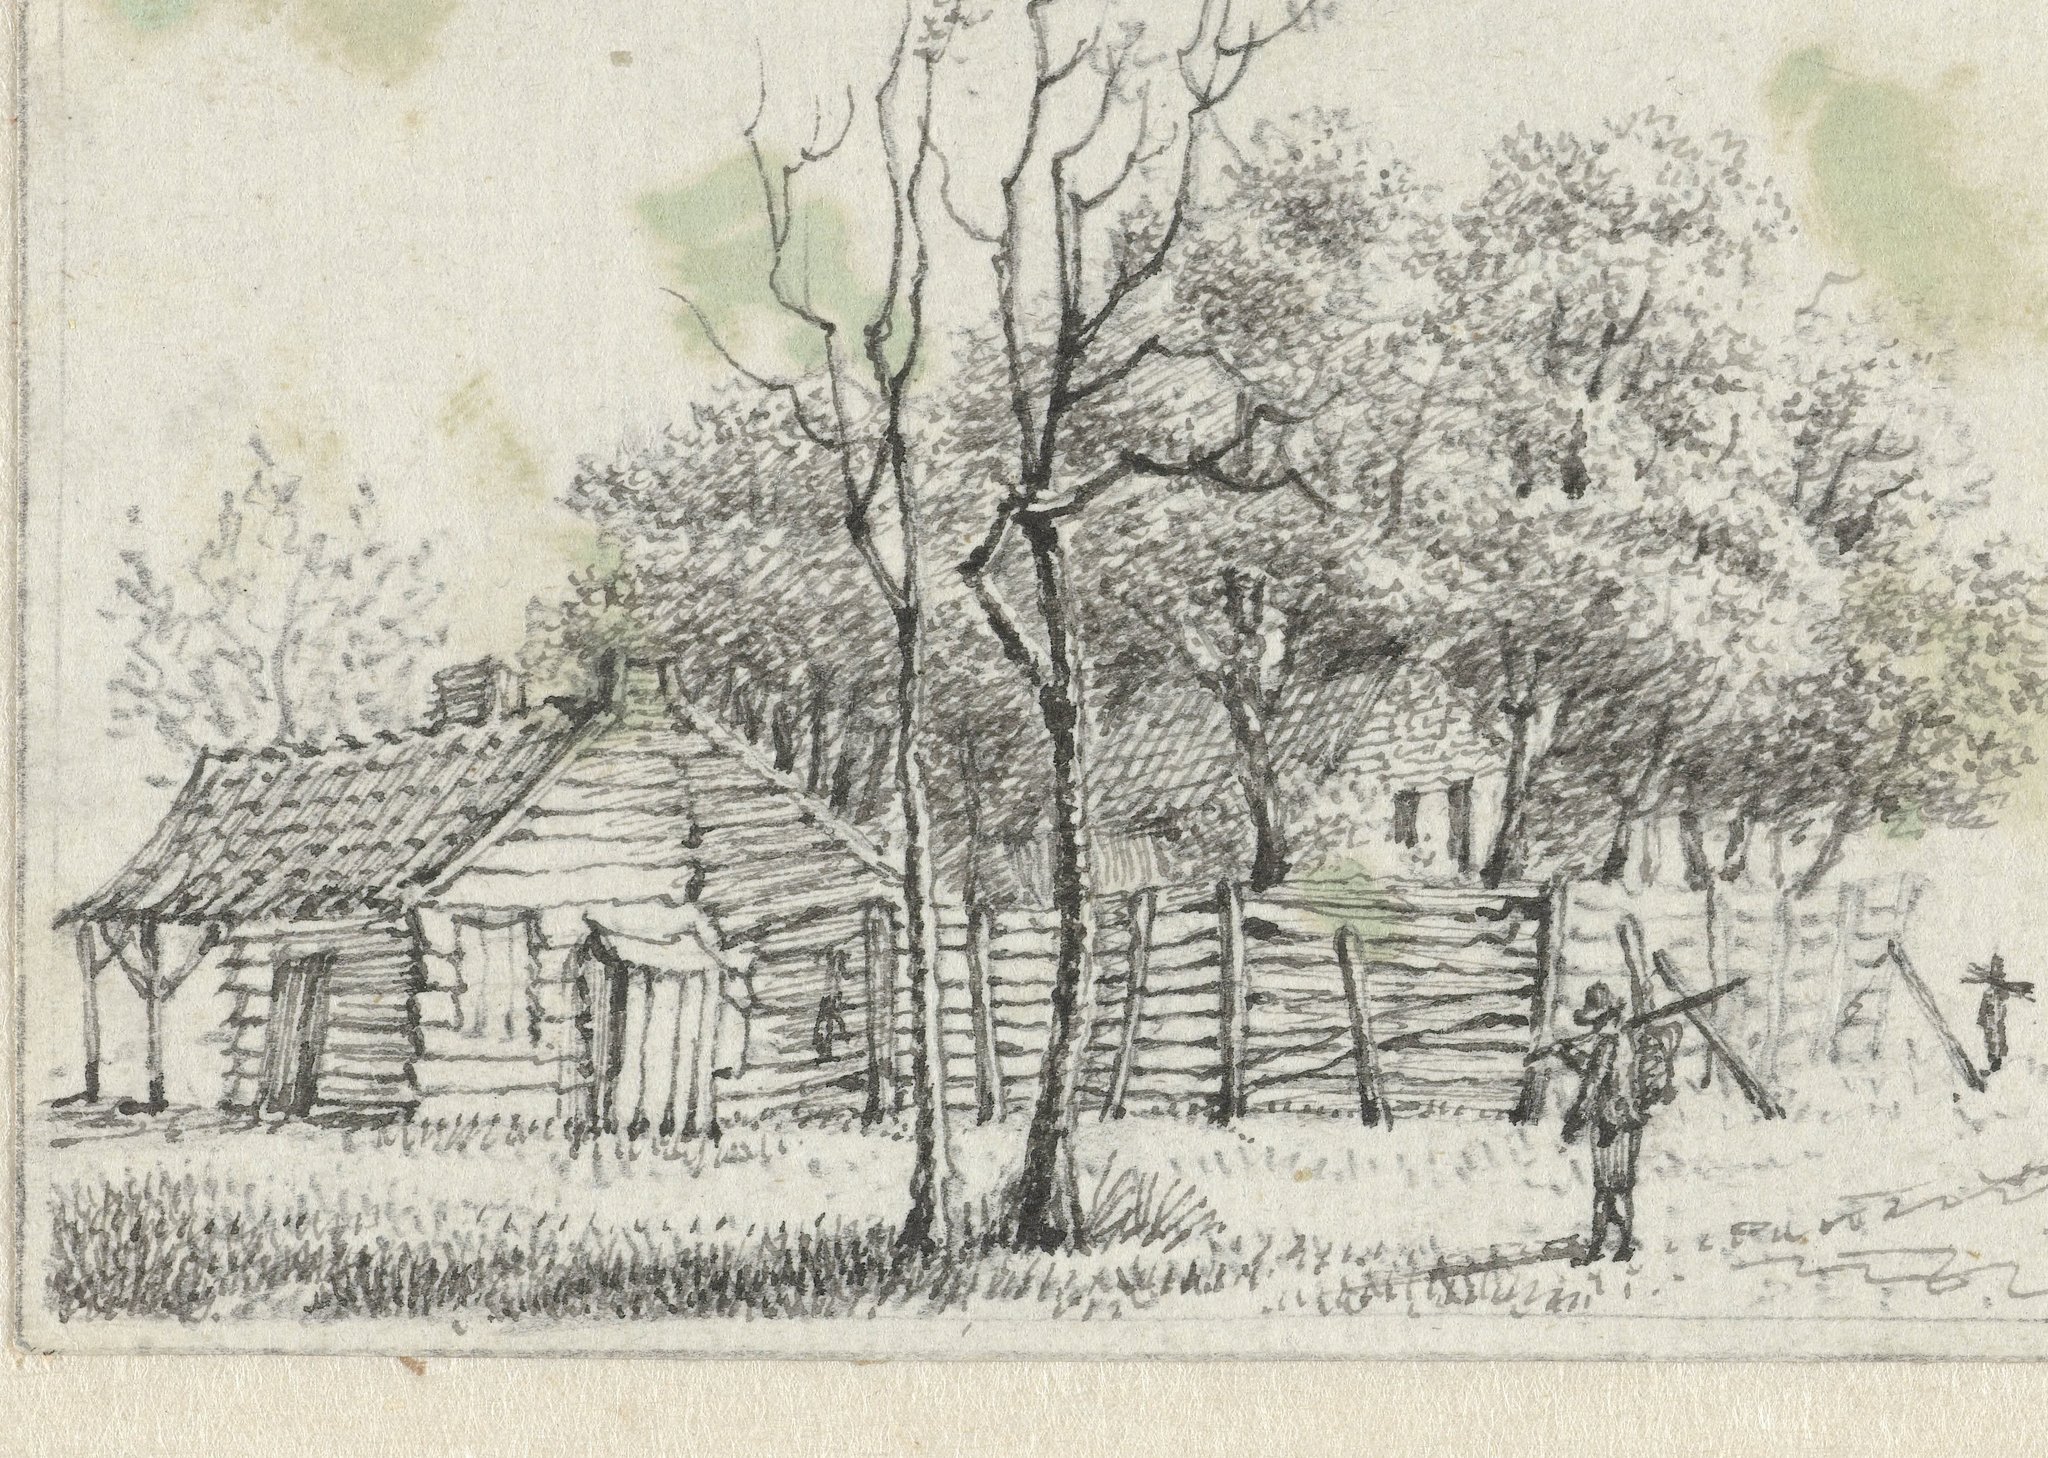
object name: design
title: Huisjes met houten schutting tussen bomen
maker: johannes ludovicus van den bos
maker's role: draughtsman, print maker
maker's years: 1800-1827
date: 1810-1827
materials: chalk, ink, paper, pencil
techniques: pen